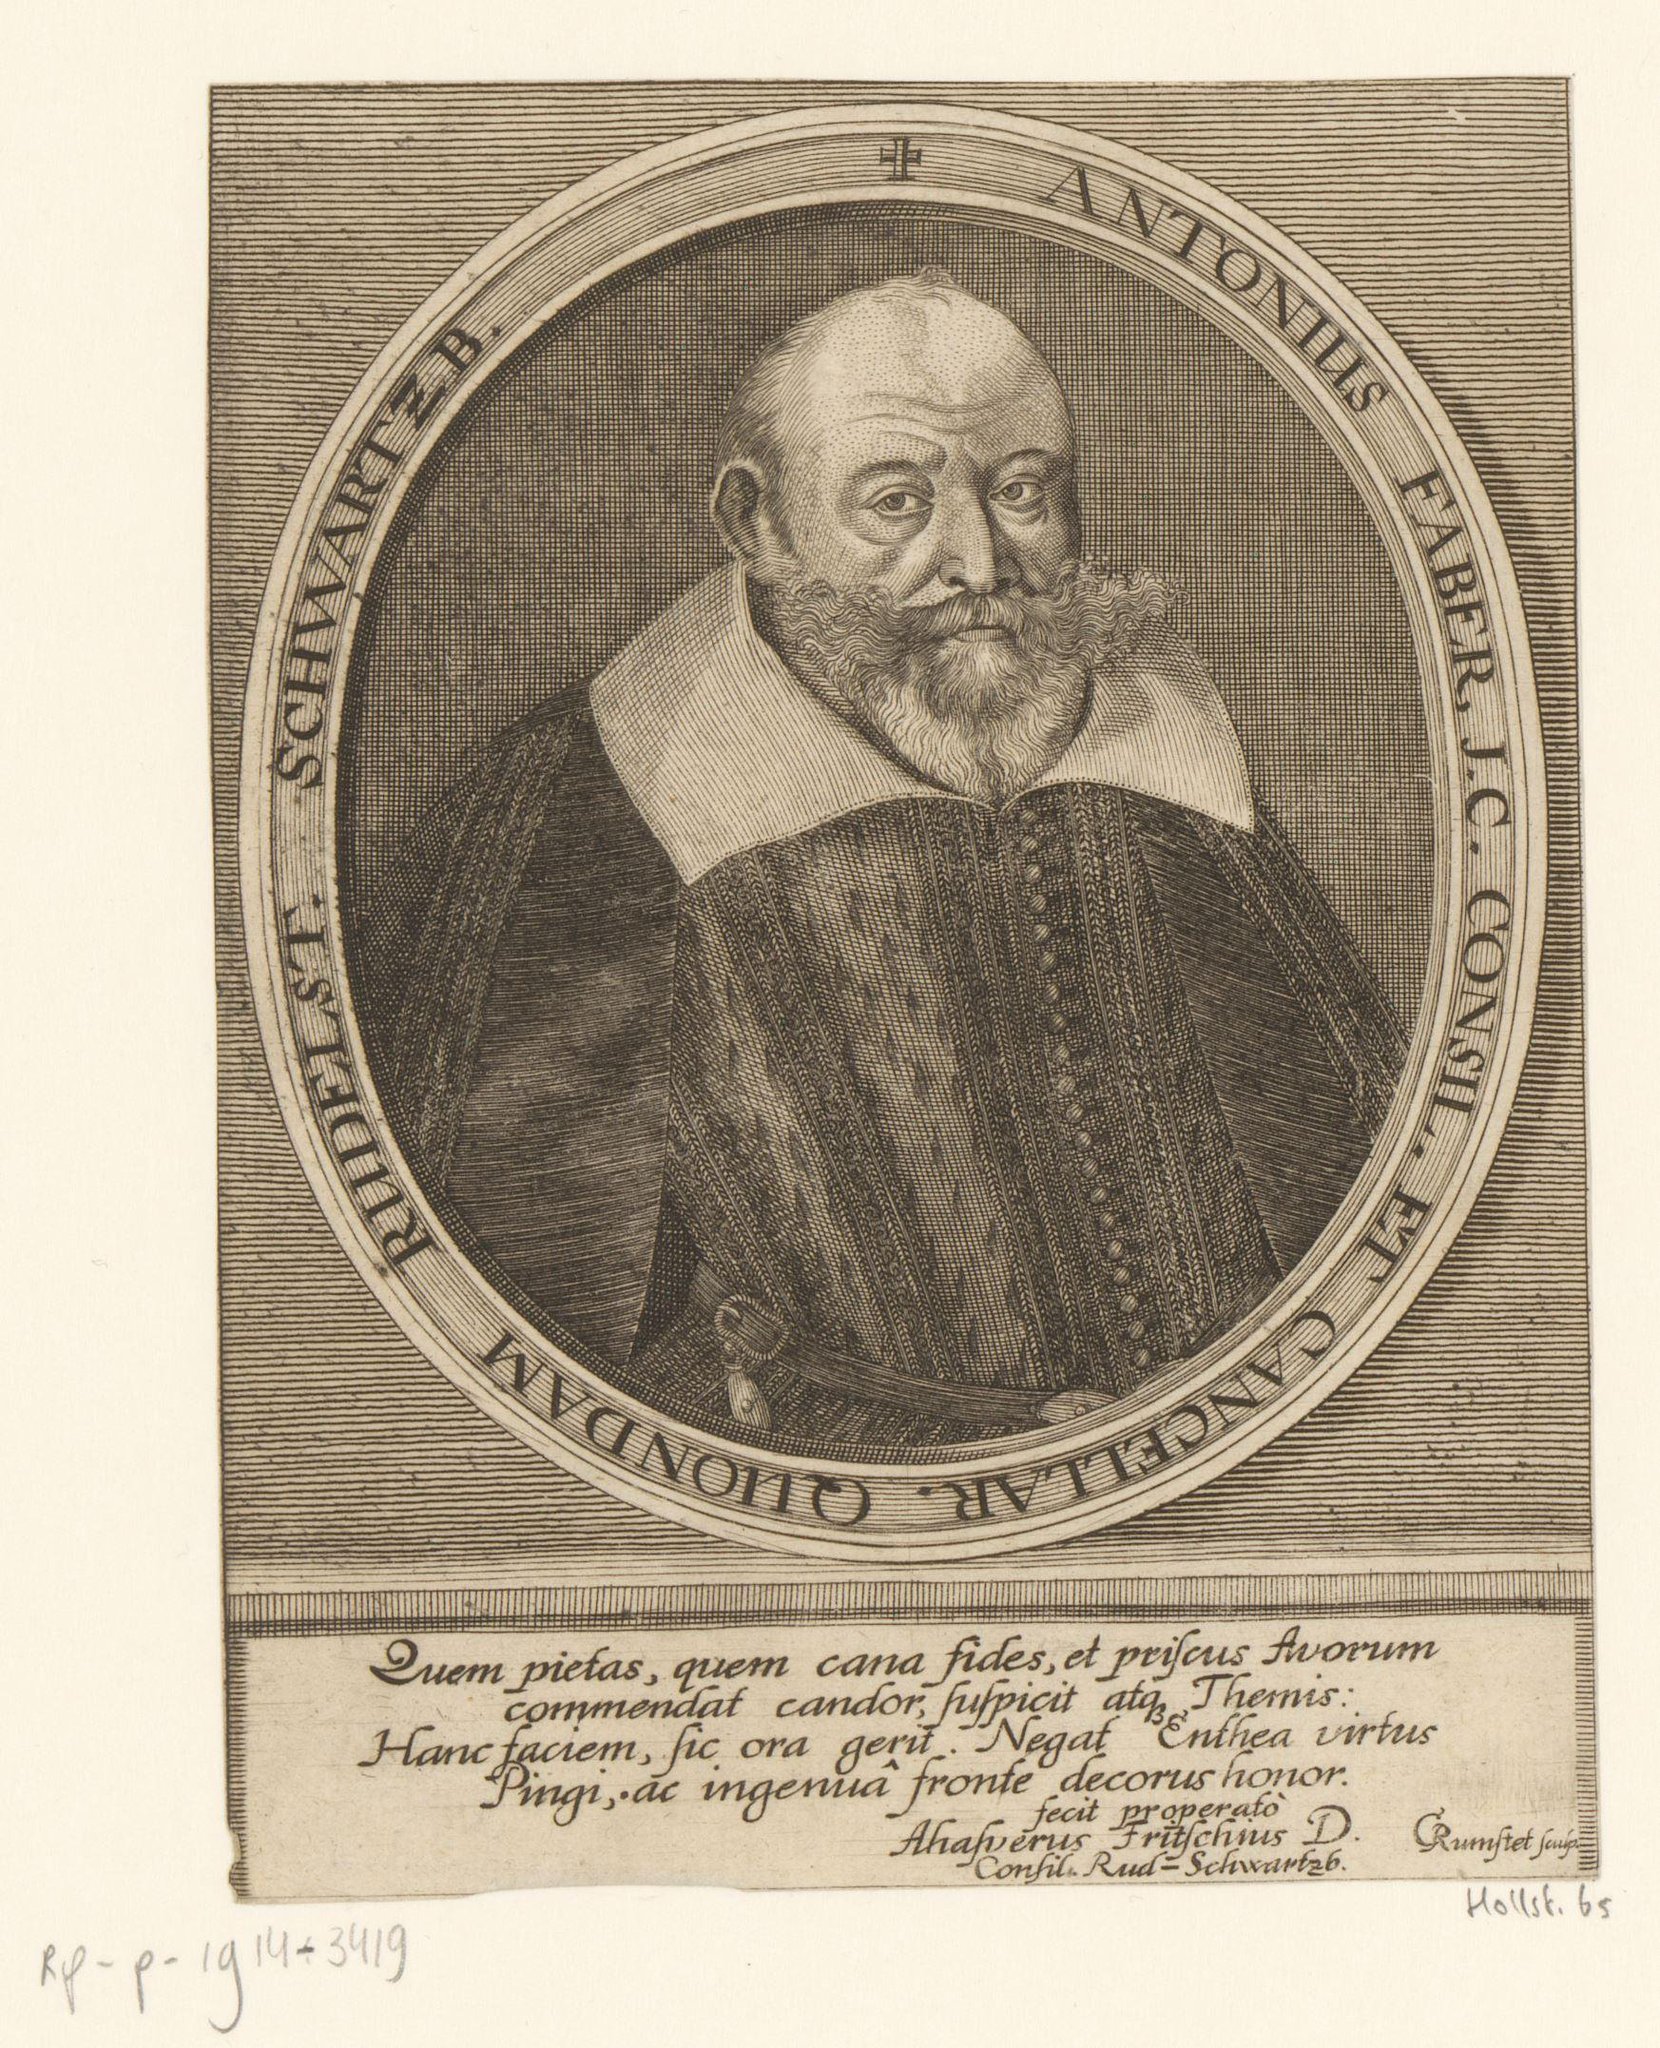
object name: print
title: Portret van Anton Faber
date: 1665-1721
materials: paper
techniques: engraving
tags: historical persons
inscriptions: collector's mark: Lugt 2228